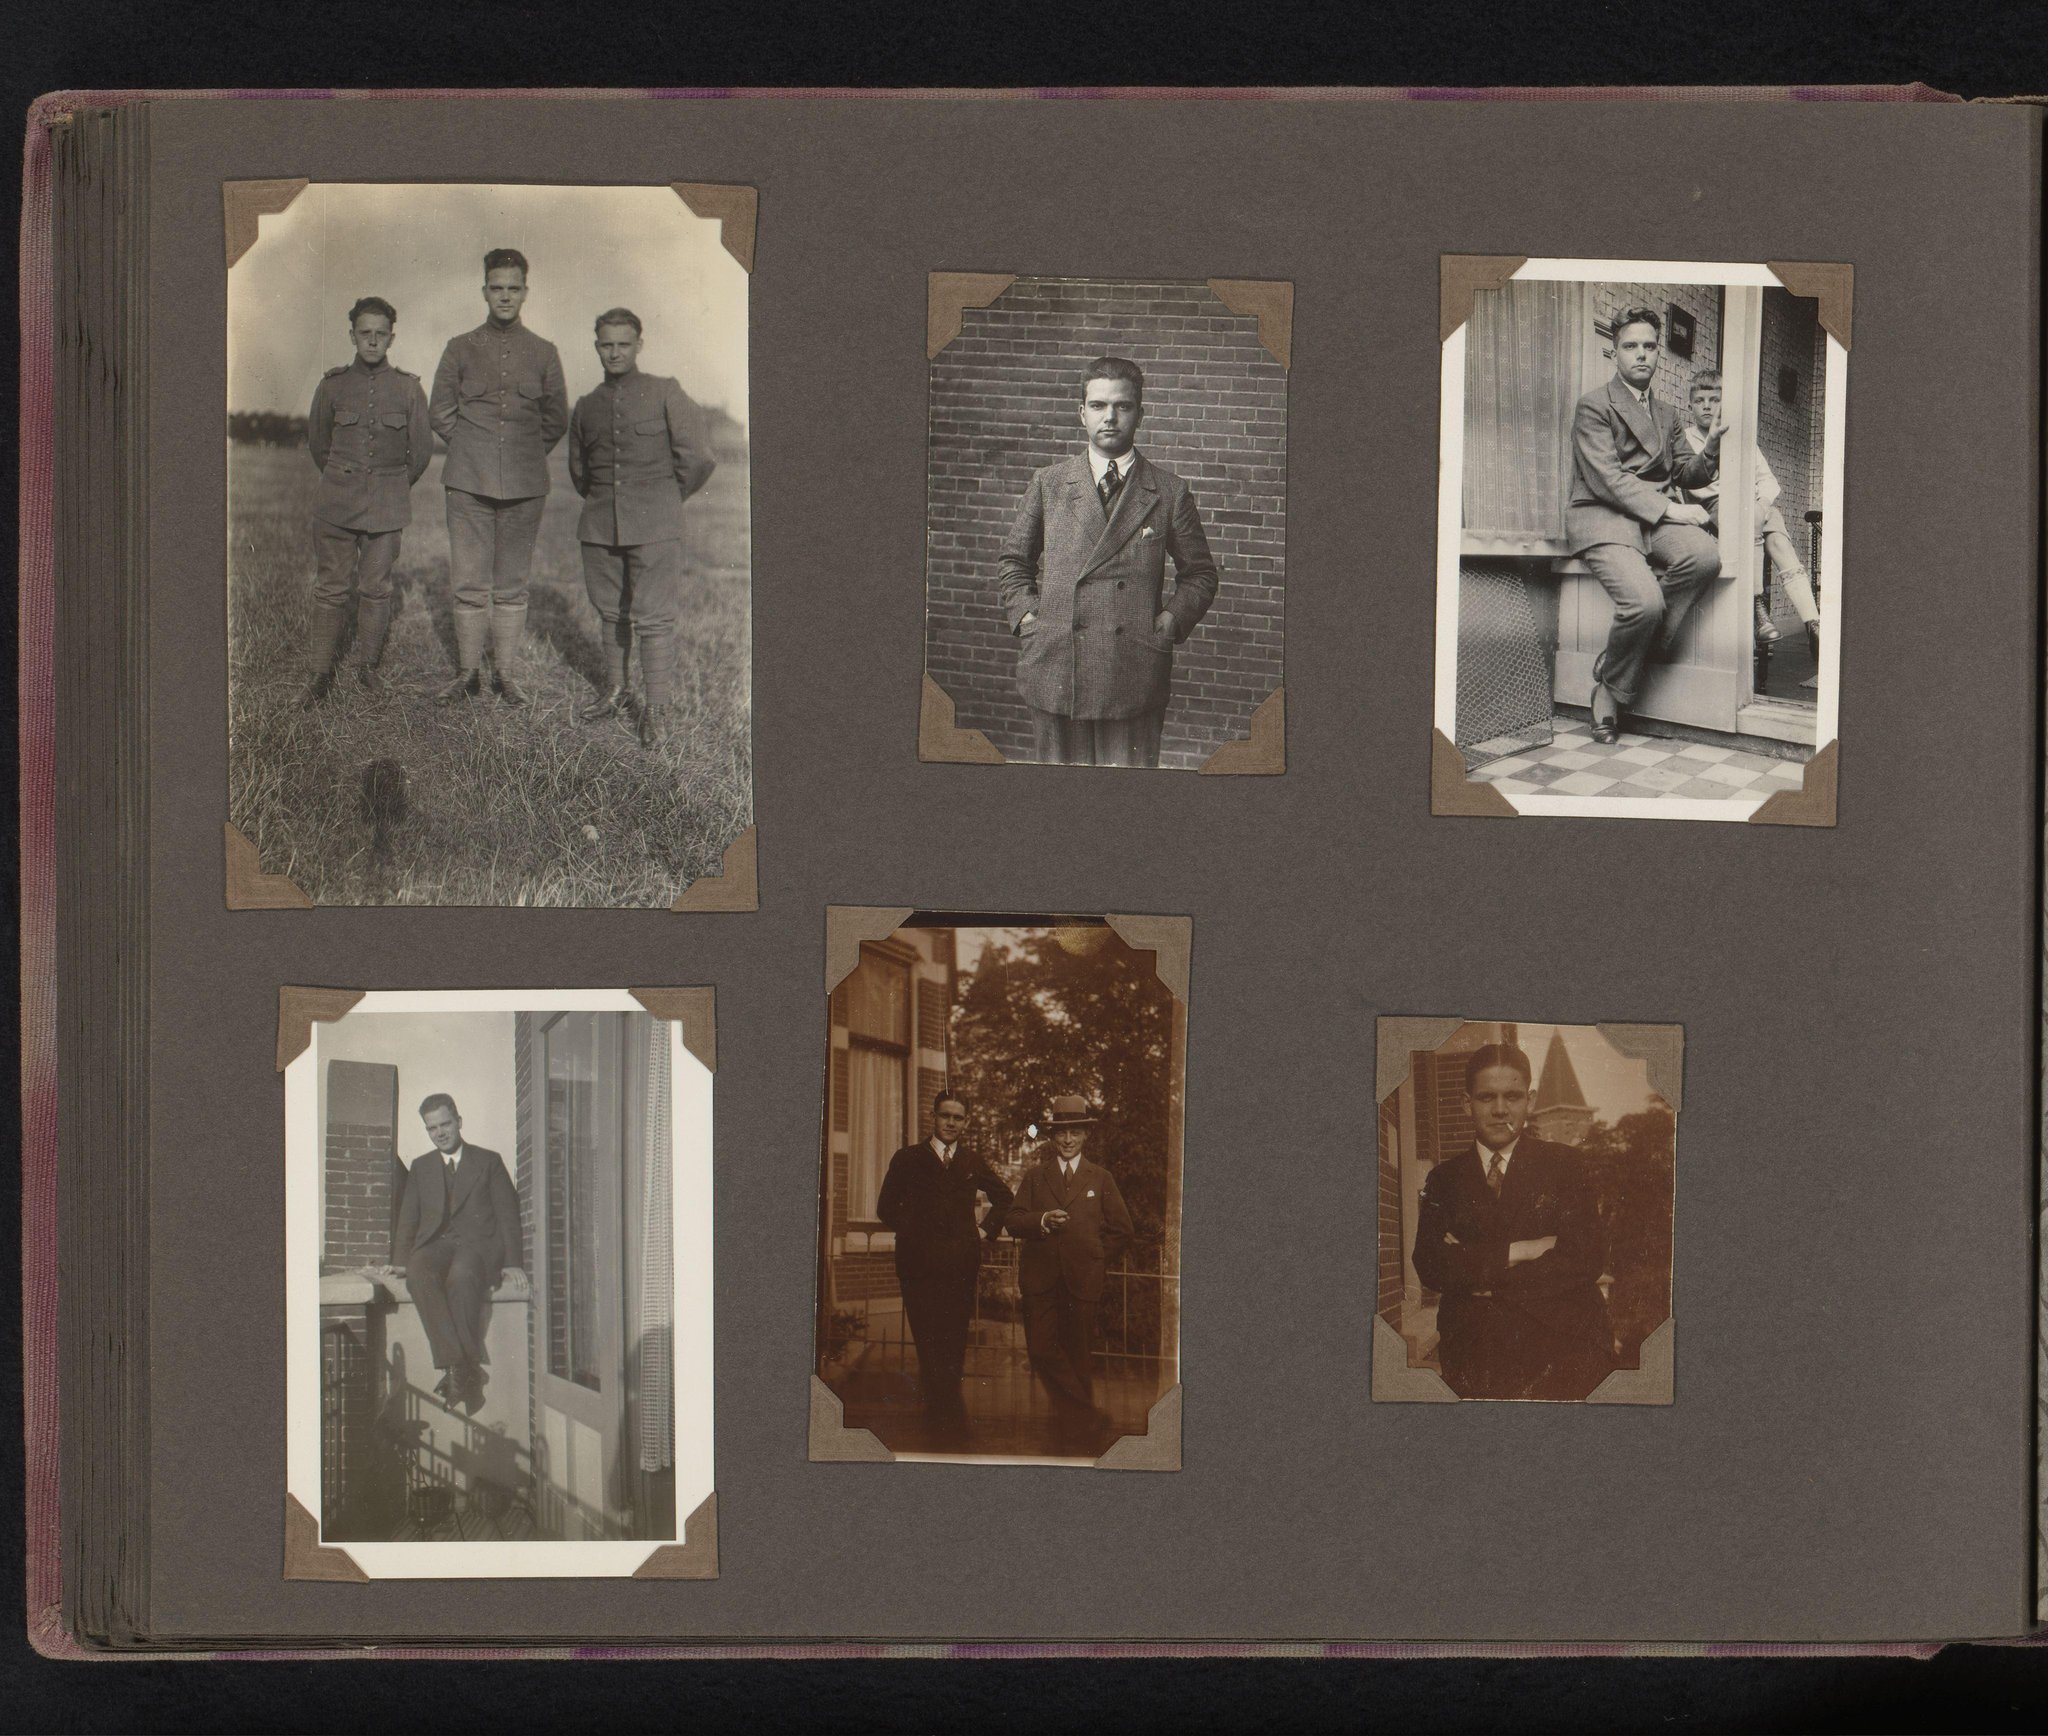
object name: album leaf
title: Vier portretten van Herman Besselaar en twee portretten van een kennis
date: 1930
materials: cardboard, photographic support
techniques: gelatin silver print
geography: netherlands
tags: herman besselaar, historical persons, anonymous historical persons portrayed in a group, in a group-portrait, netherlands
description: Op twee portretten is Herman Besselaar afgebeeld met andere personen: twee mannen in werkkleding en een kind. De overige twee portretten zijn portretten van een kennis, waarvan één samen met een andere kennis van de Besselaars. Deze foto's maken deel uit van een album.